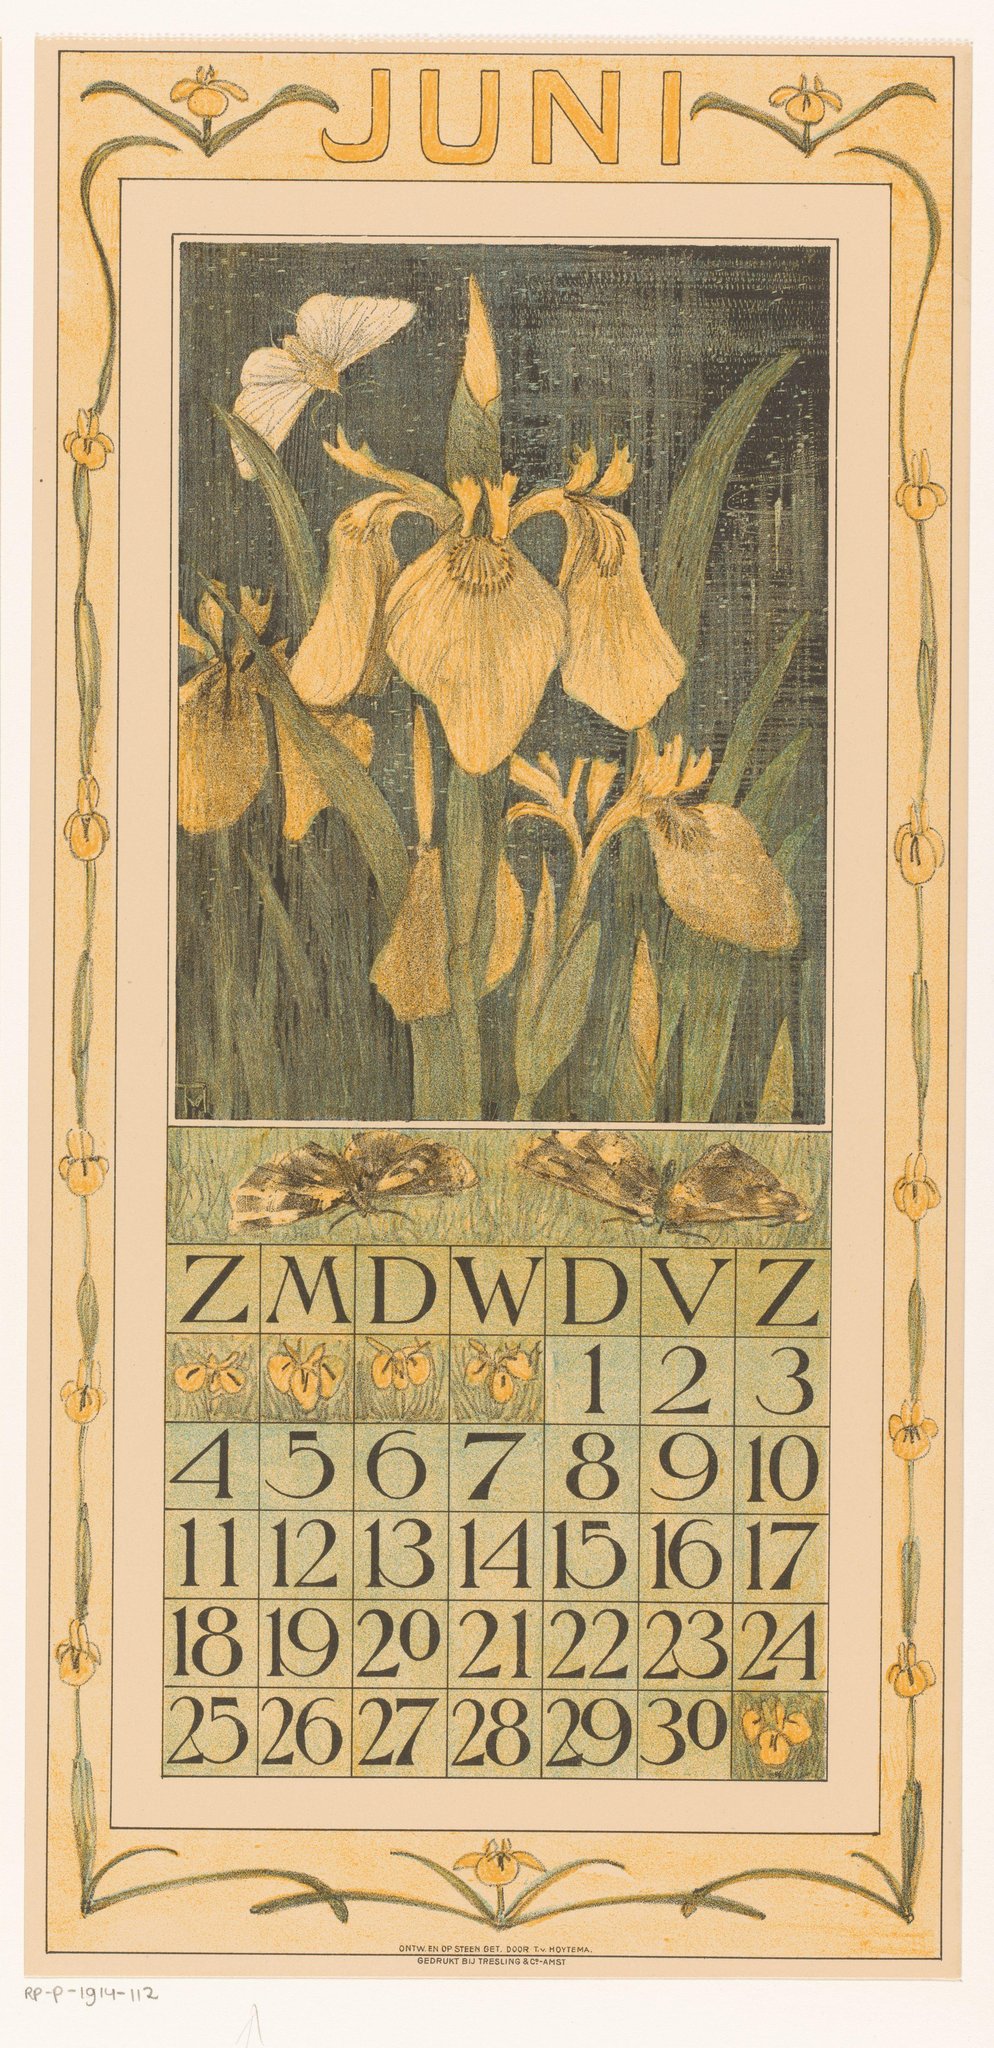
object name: calendar leaf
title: Lisbloemen en vlinder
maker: theo van hoytema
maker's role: draughtsman, painter, print maker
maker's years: 1863-1917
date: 1910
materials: paper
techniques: lithograph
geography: the hague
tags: insects: moth, flowers: iris, june ~ other concepts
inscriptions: collector's mark: Lugt 2228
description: In de ornamentrand lissen of irissen en motten. Bovenaan het blad een scheurlijn.